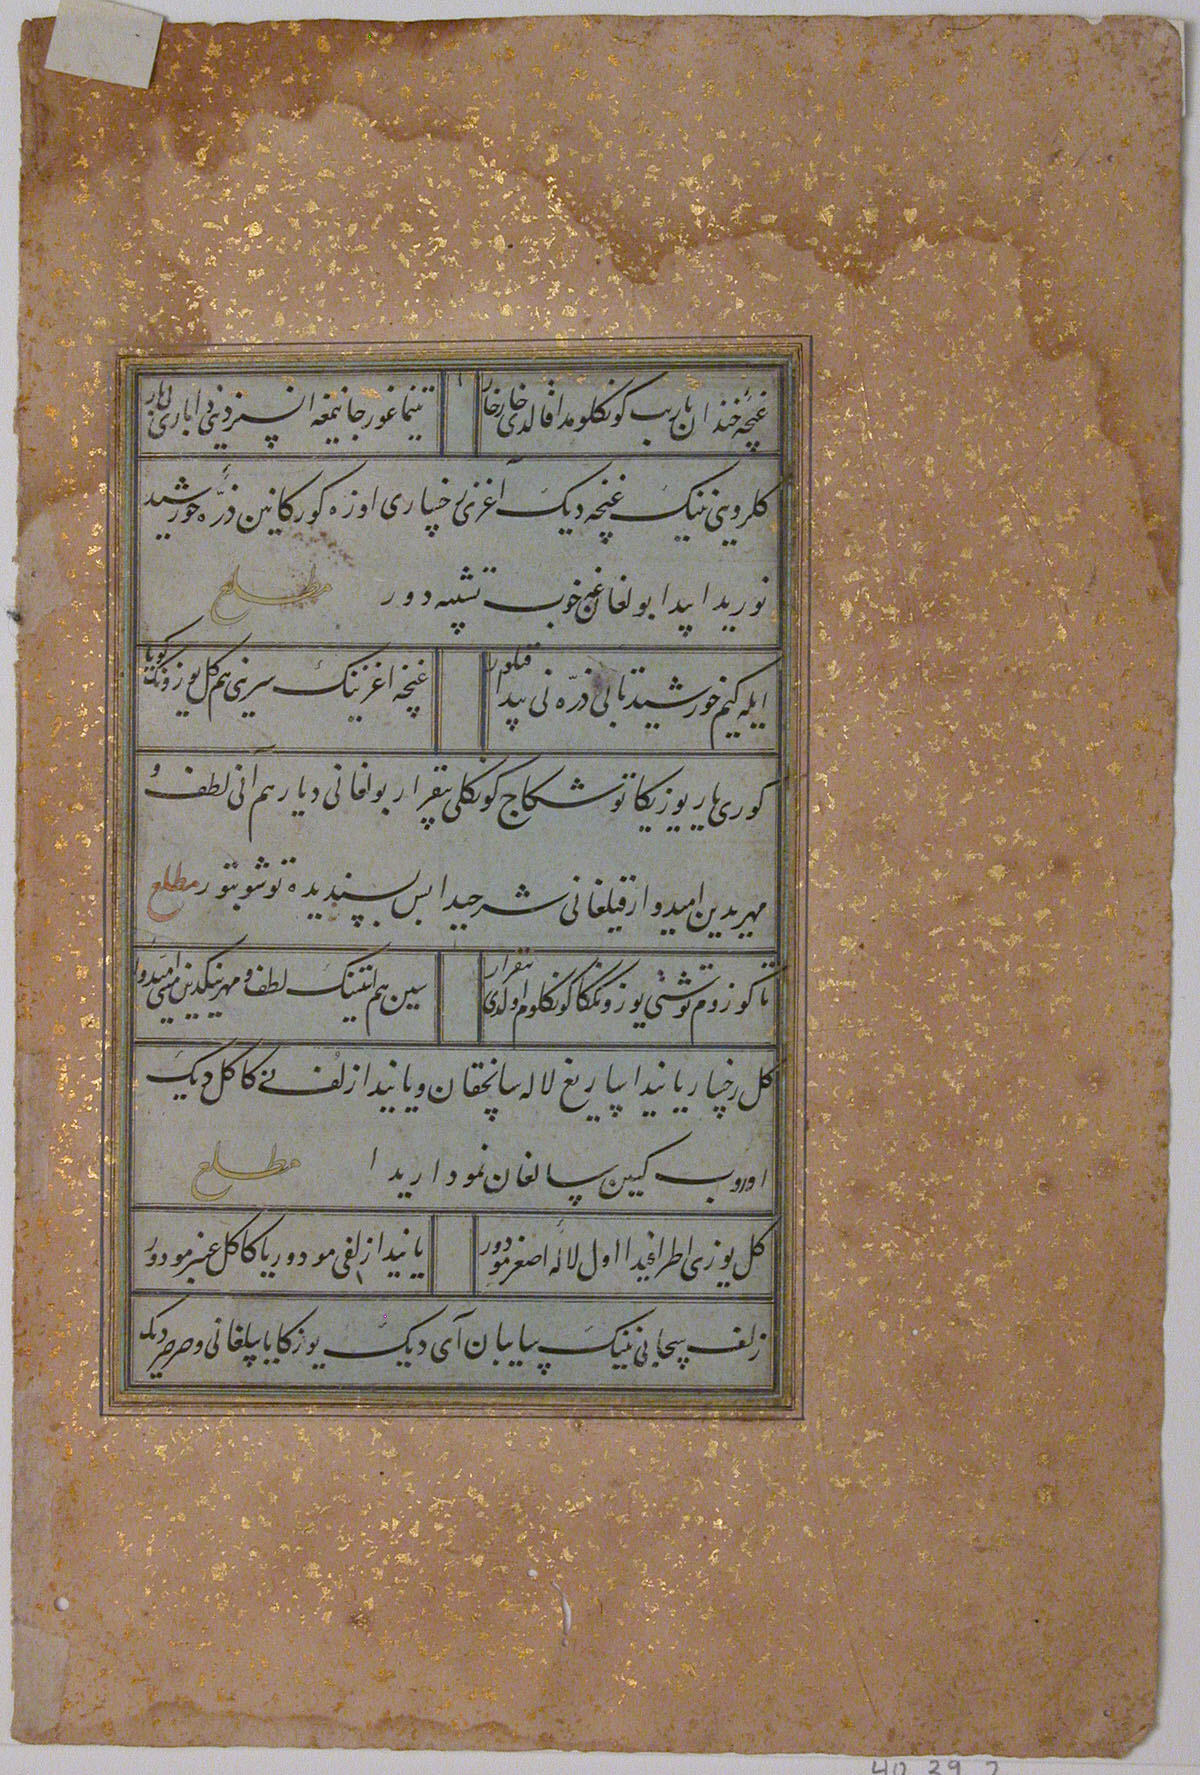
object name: folio from an illustrated manuscript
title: Folio from a Manuscript by Mir Ali Shir Nava'i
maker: mir ali shir nava'i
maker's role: author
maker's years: 1416-1526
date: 1501-1533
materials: gold, ink, paper, watercolor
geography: uzbekistan